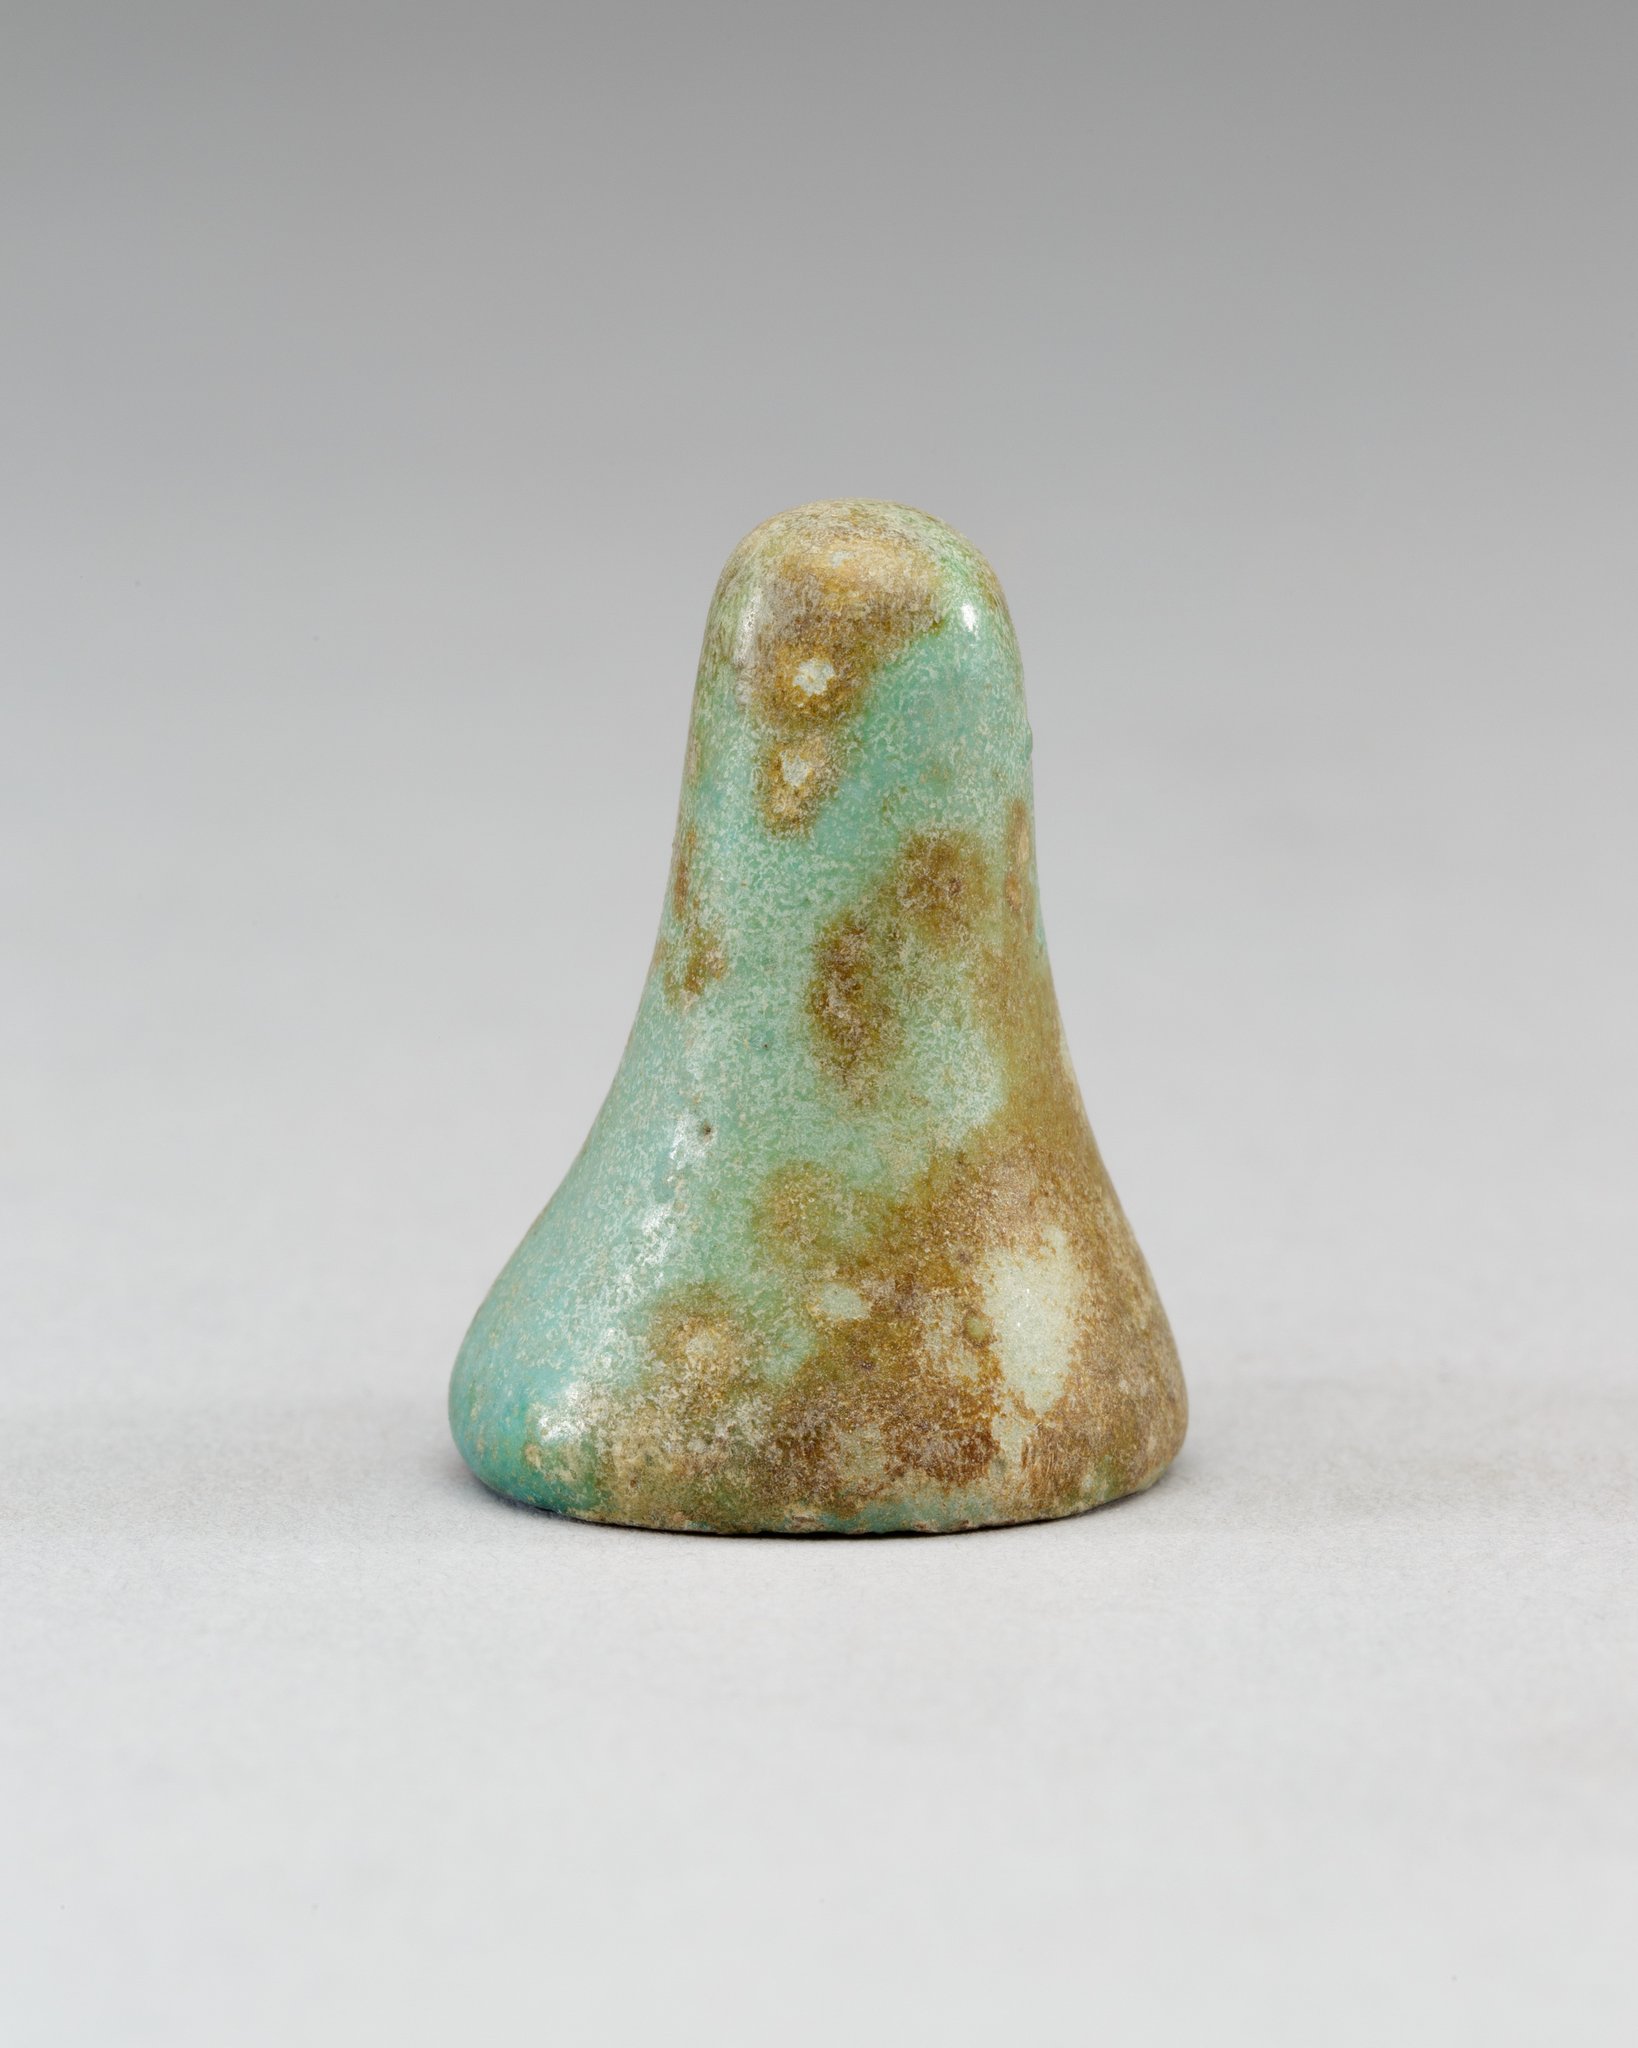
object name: game piece, conical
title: Conical Game Piece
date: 1504-1447 BCE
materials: faience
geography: egypt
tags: games